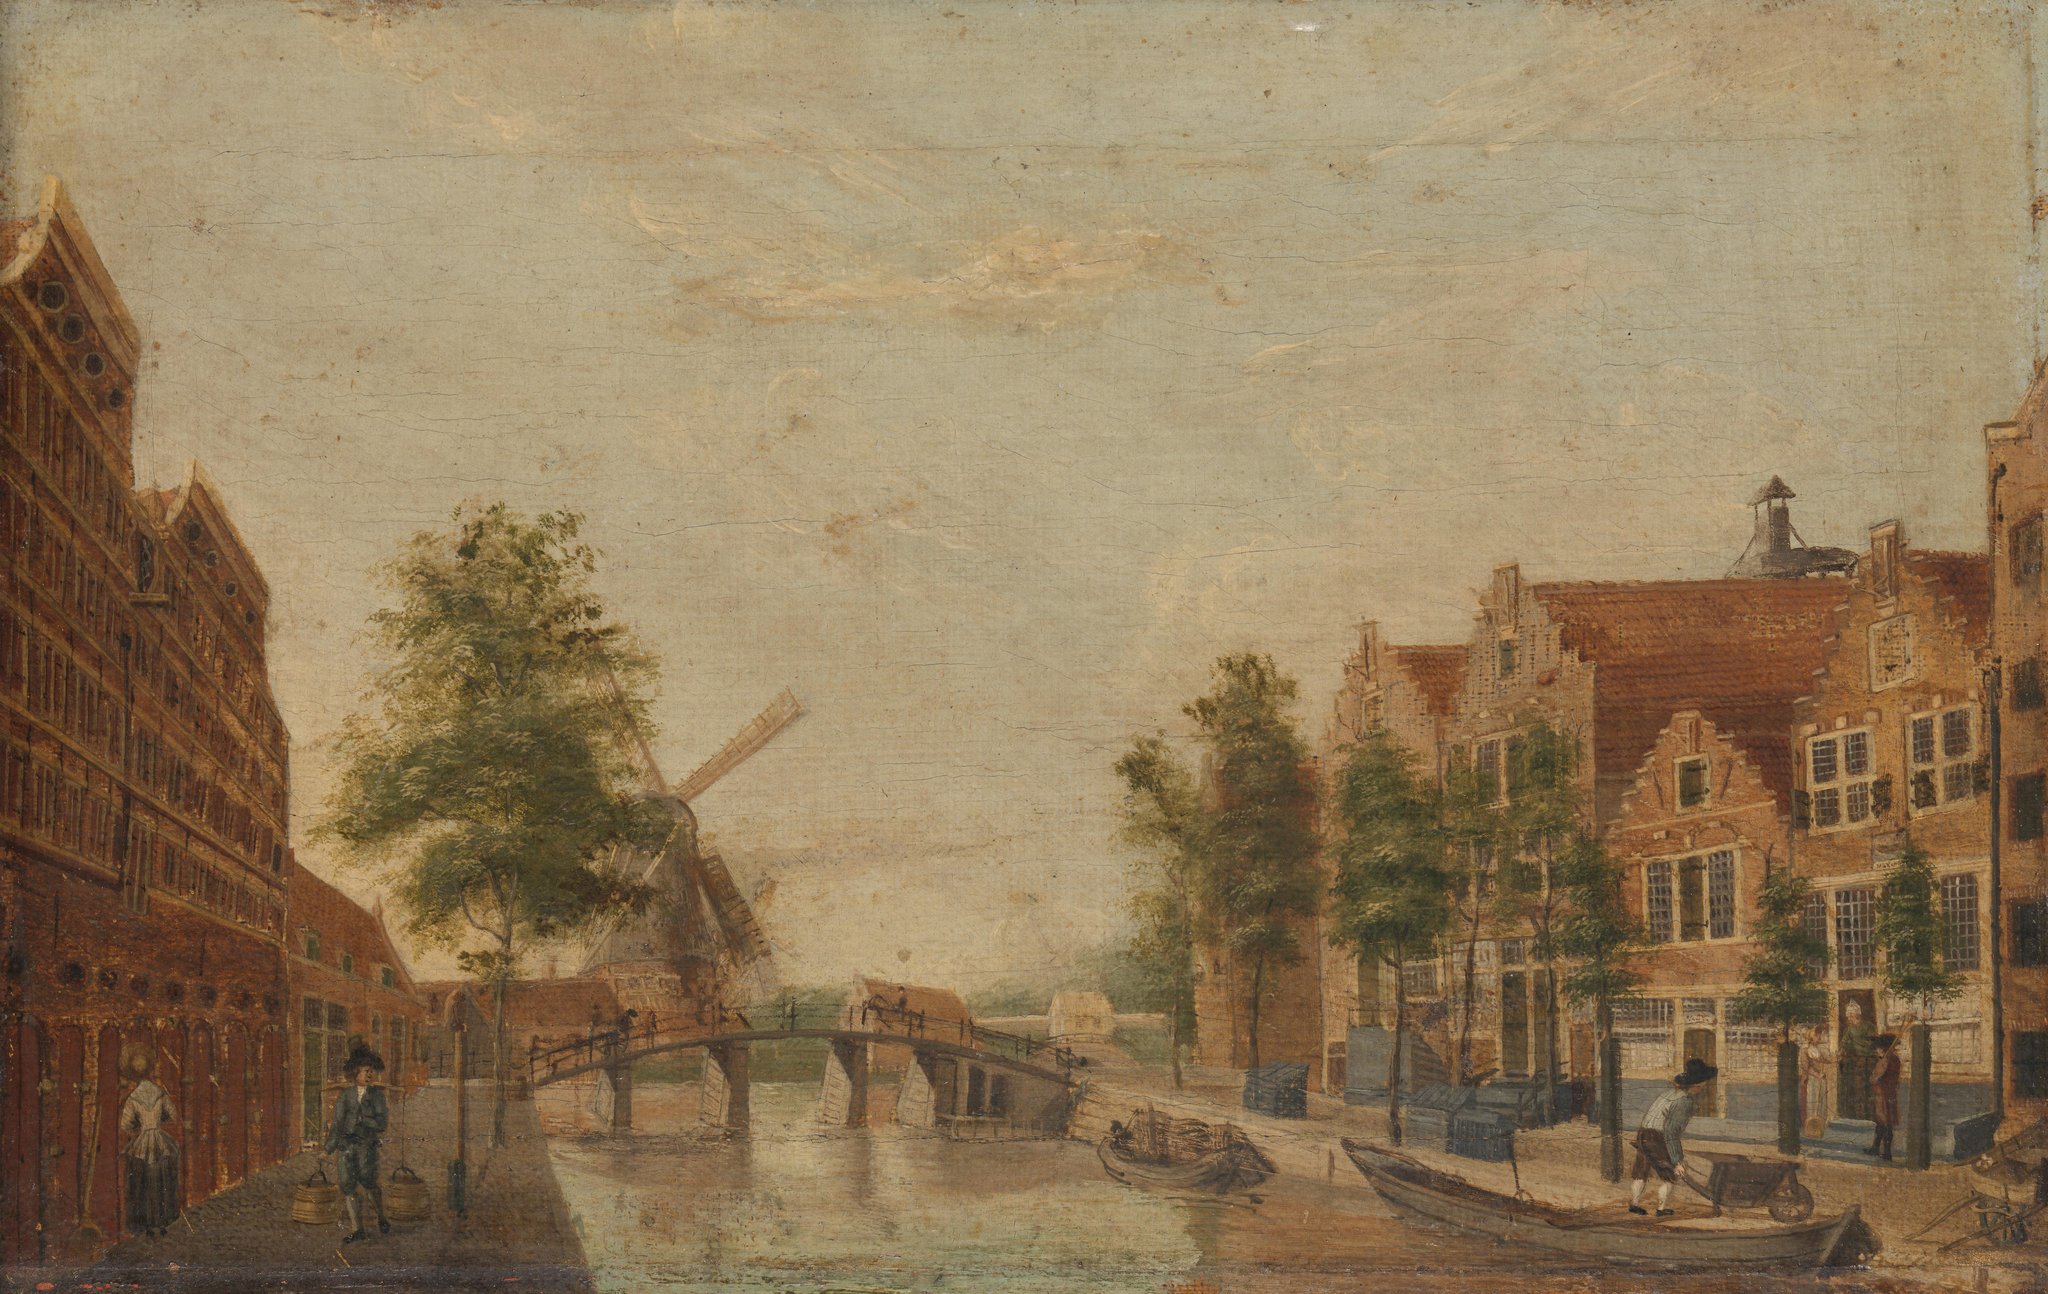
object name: painting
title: The Brouwersgracht in Amsterdam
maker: Anonymous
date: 1750-1799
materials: canvas, oil, panel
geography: amsterdam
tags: canal, public road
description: Gezicht op de Brouwersgracht te Amsterdam. Aan de rechterkant een man met een kruiwagen op een schuit, links loopt een man met een juk. In de verte, voorbij de brug, staat een molen.